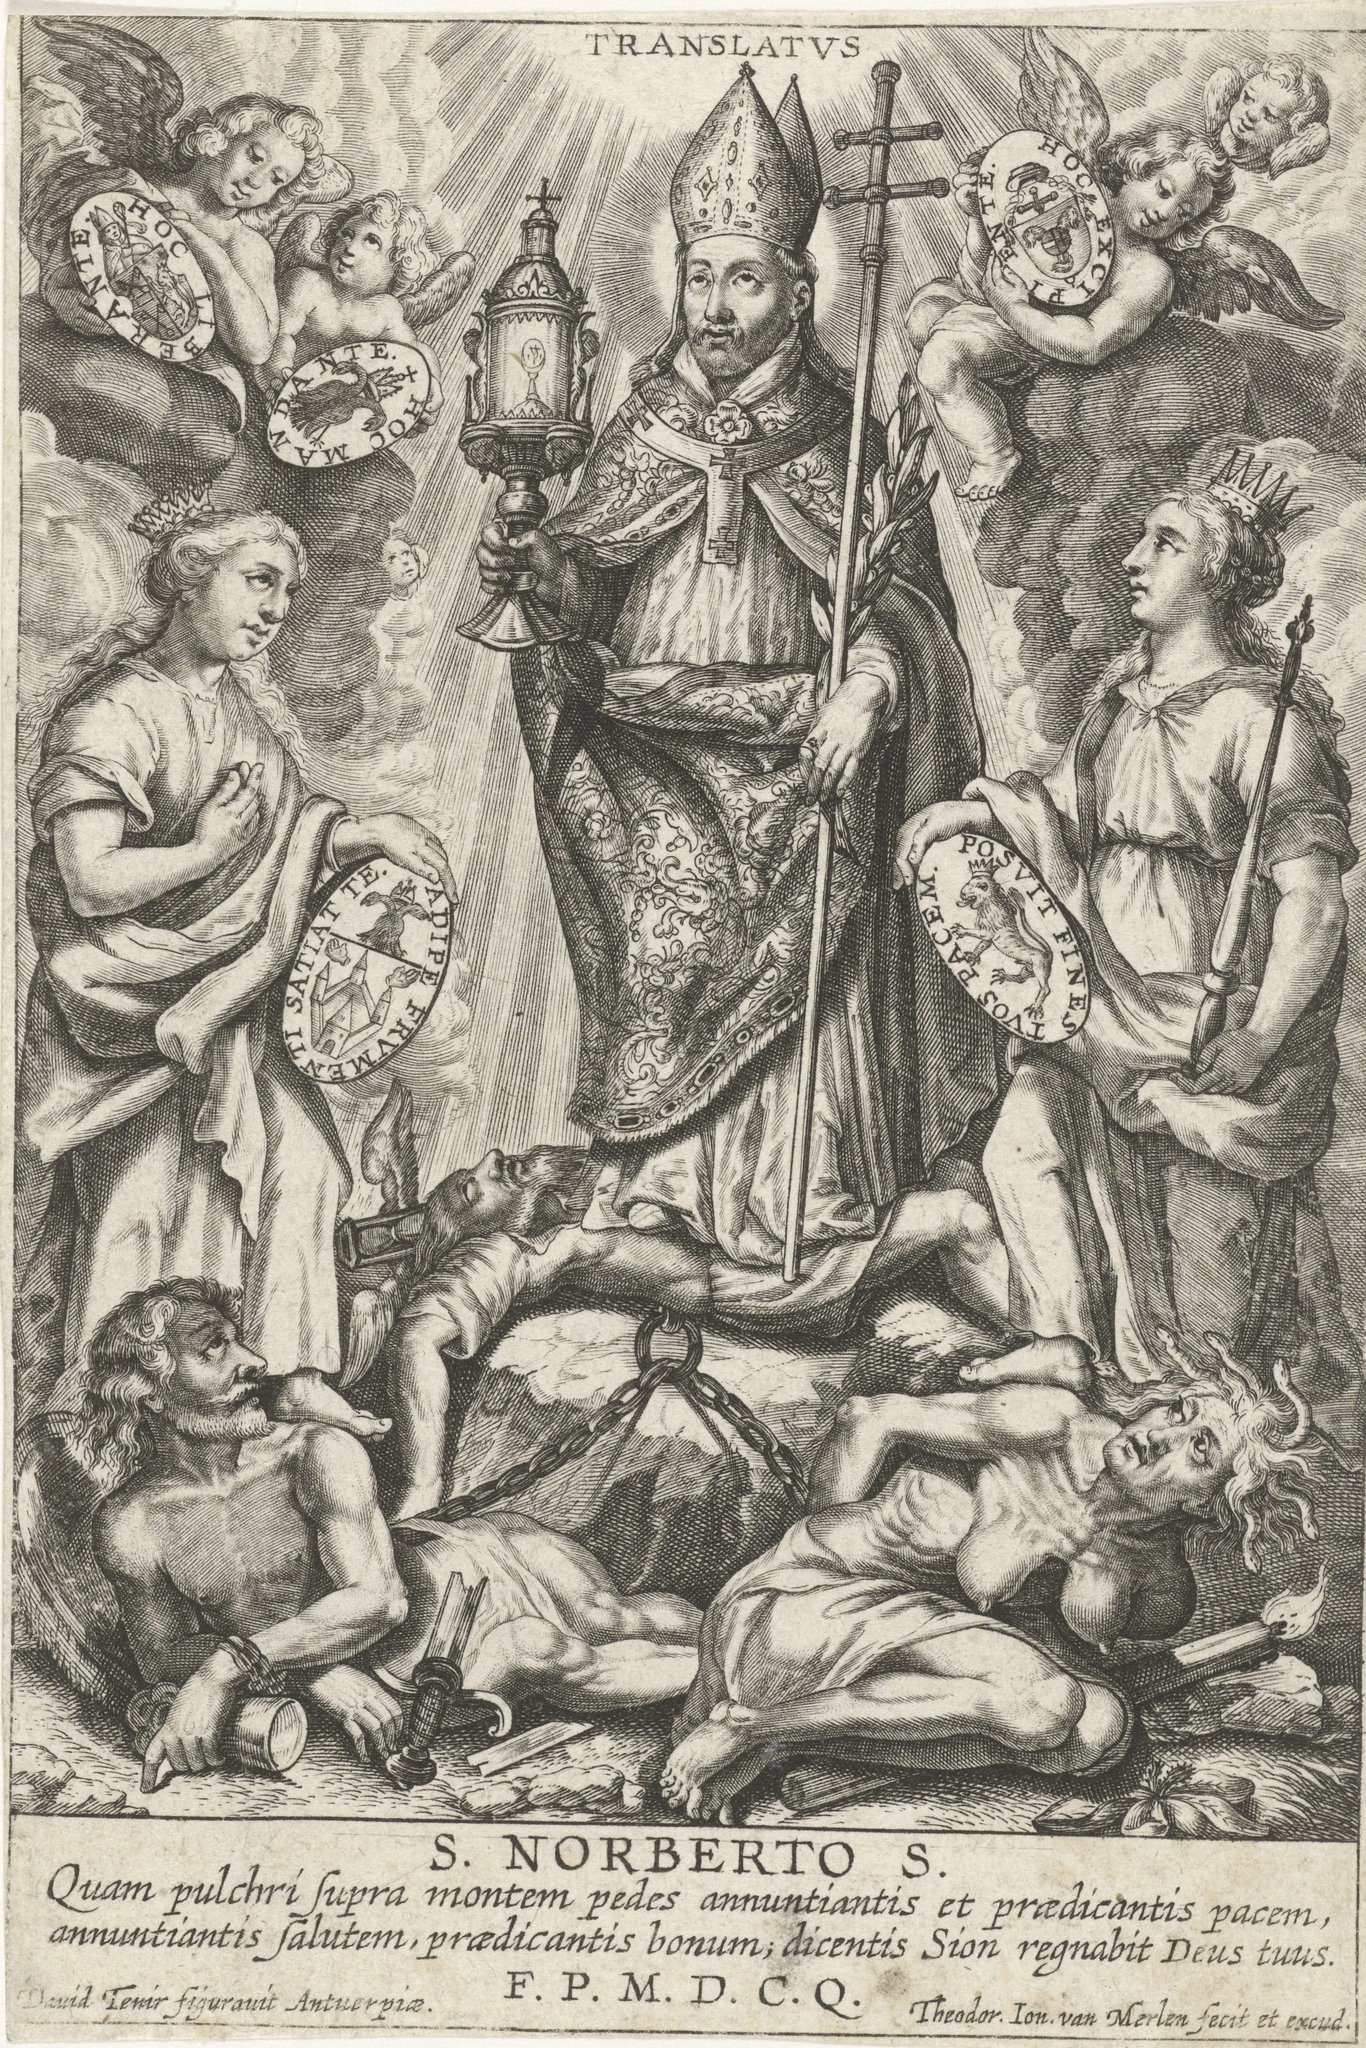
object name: print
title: H. Norbert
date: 1619-1672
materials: paper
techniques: engraving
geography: antwerp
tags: st. norbert trampling the heretic tankelin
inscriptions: collector's mark: Lugt 2228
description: De heilige Norbert met bisschopsstaf en mijter. In de hand een monstrans met een hostie. De heilige staat op de personificatie van de Tijd die aan een rots geketend is.